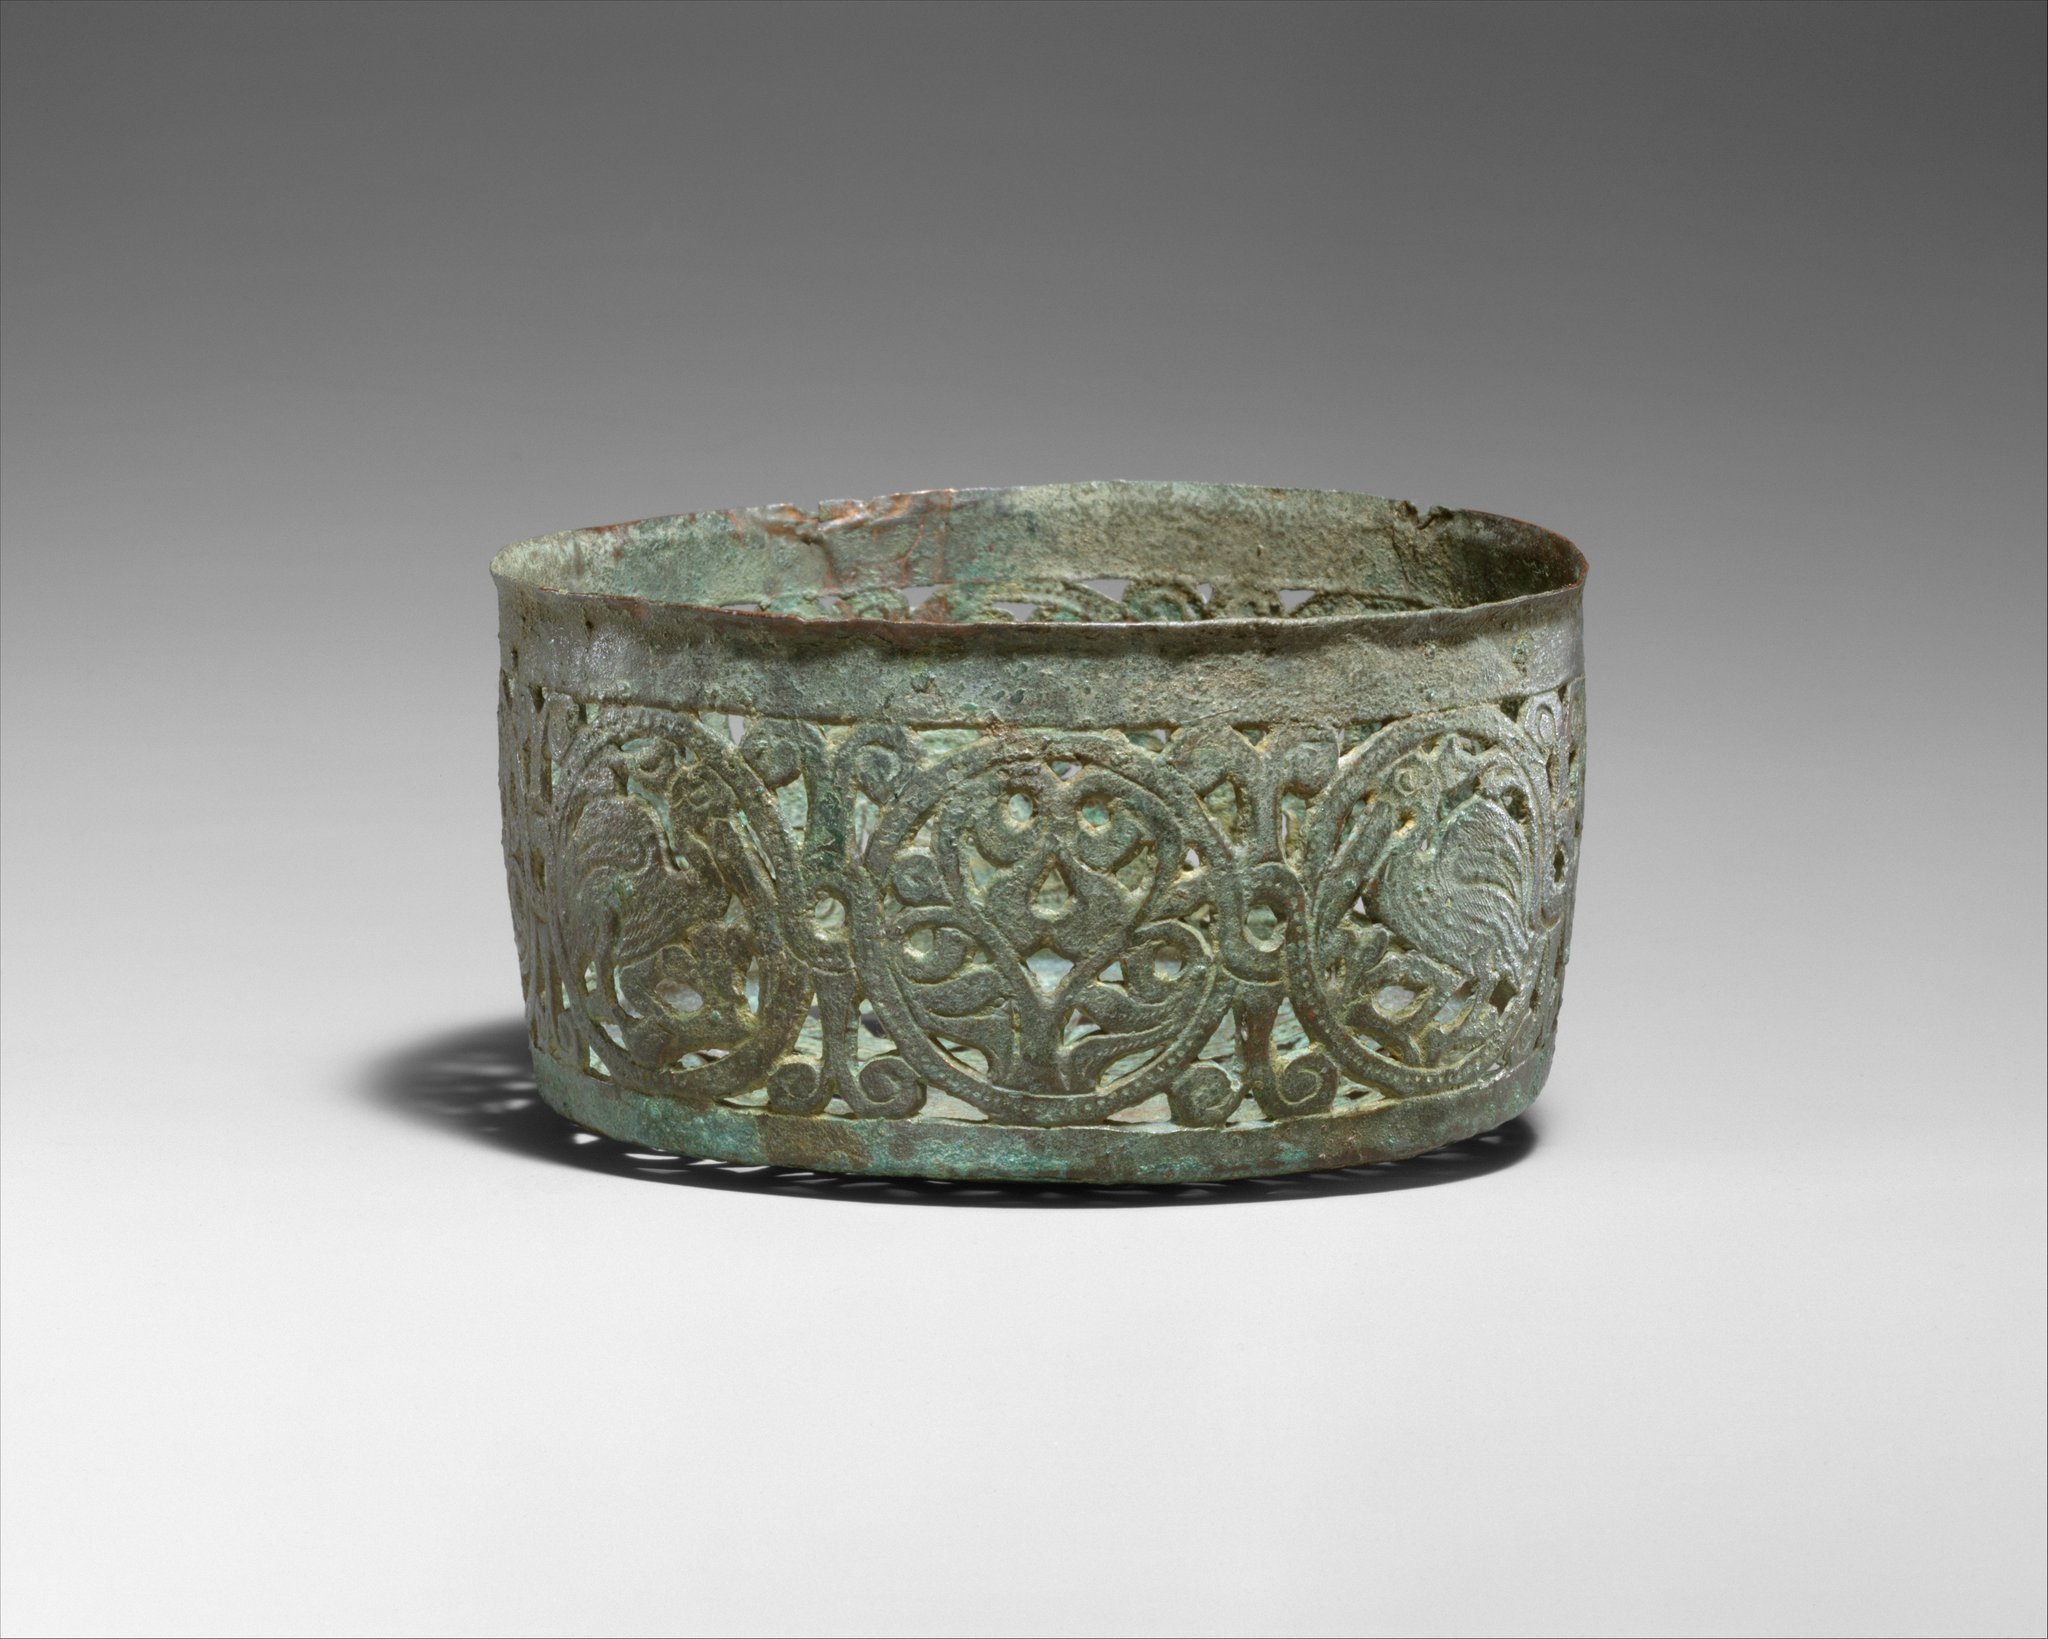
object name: basin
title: Vessel with Pierced Designs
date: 700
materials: bronze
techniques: chasing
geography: syria